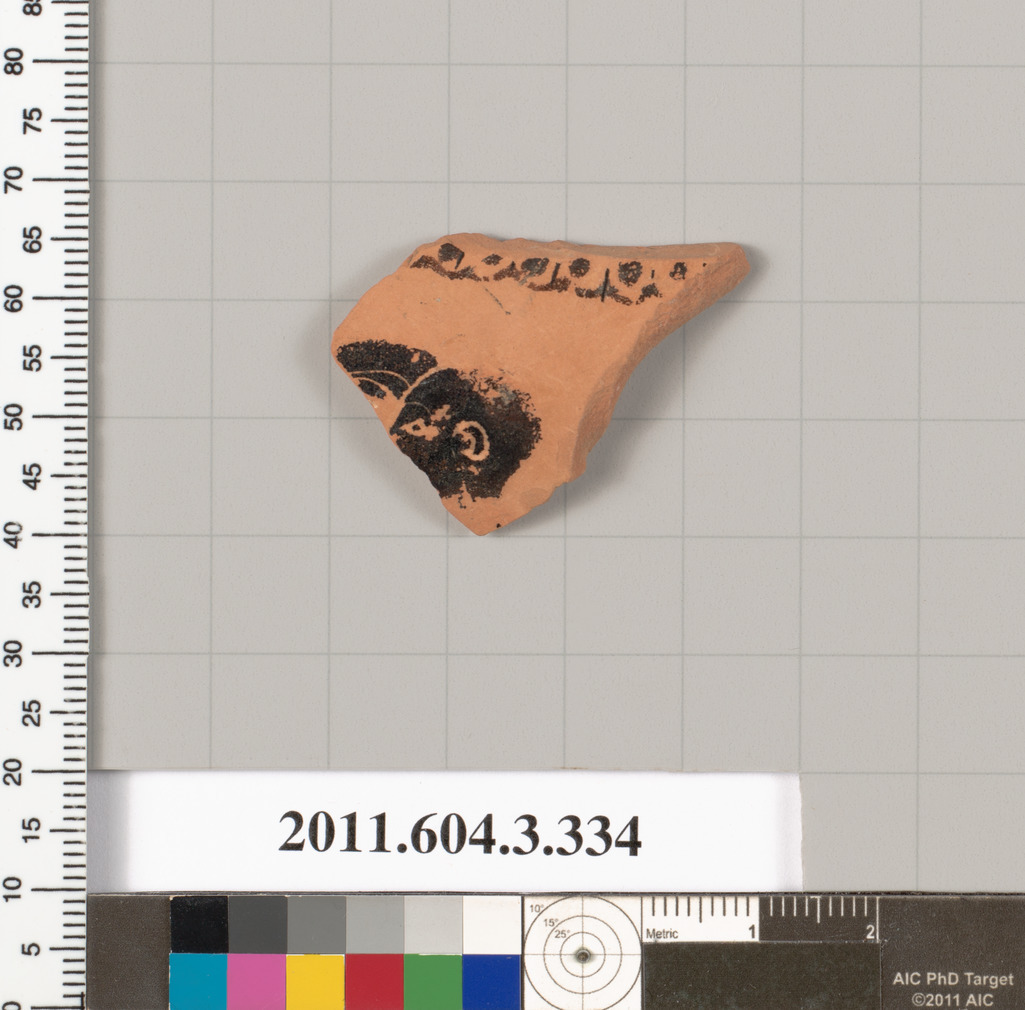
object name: neck amphora fragment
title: Terracotta fragment of a neck-amphora (jar)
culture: greek, attic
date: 500-468 BCE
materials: terracotta